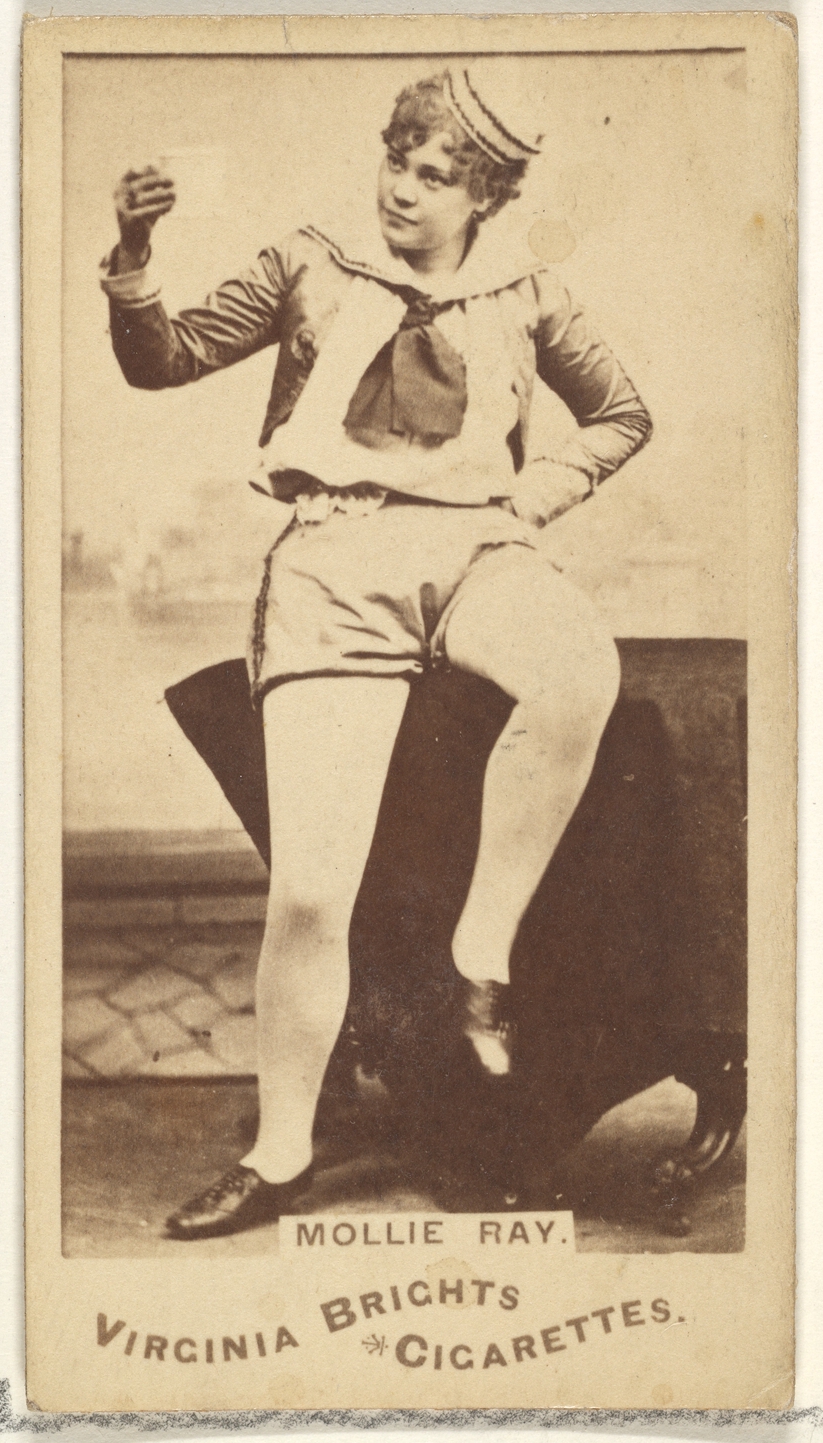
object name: photograph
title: Mollie Ray, from the Actors and Actresses series (N45, Type 1) for Virginia Brights Cigarettes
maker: allen & ginter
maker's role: publisher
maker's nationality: american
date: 1888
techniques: albumen silver print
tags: portraits,women,actresses